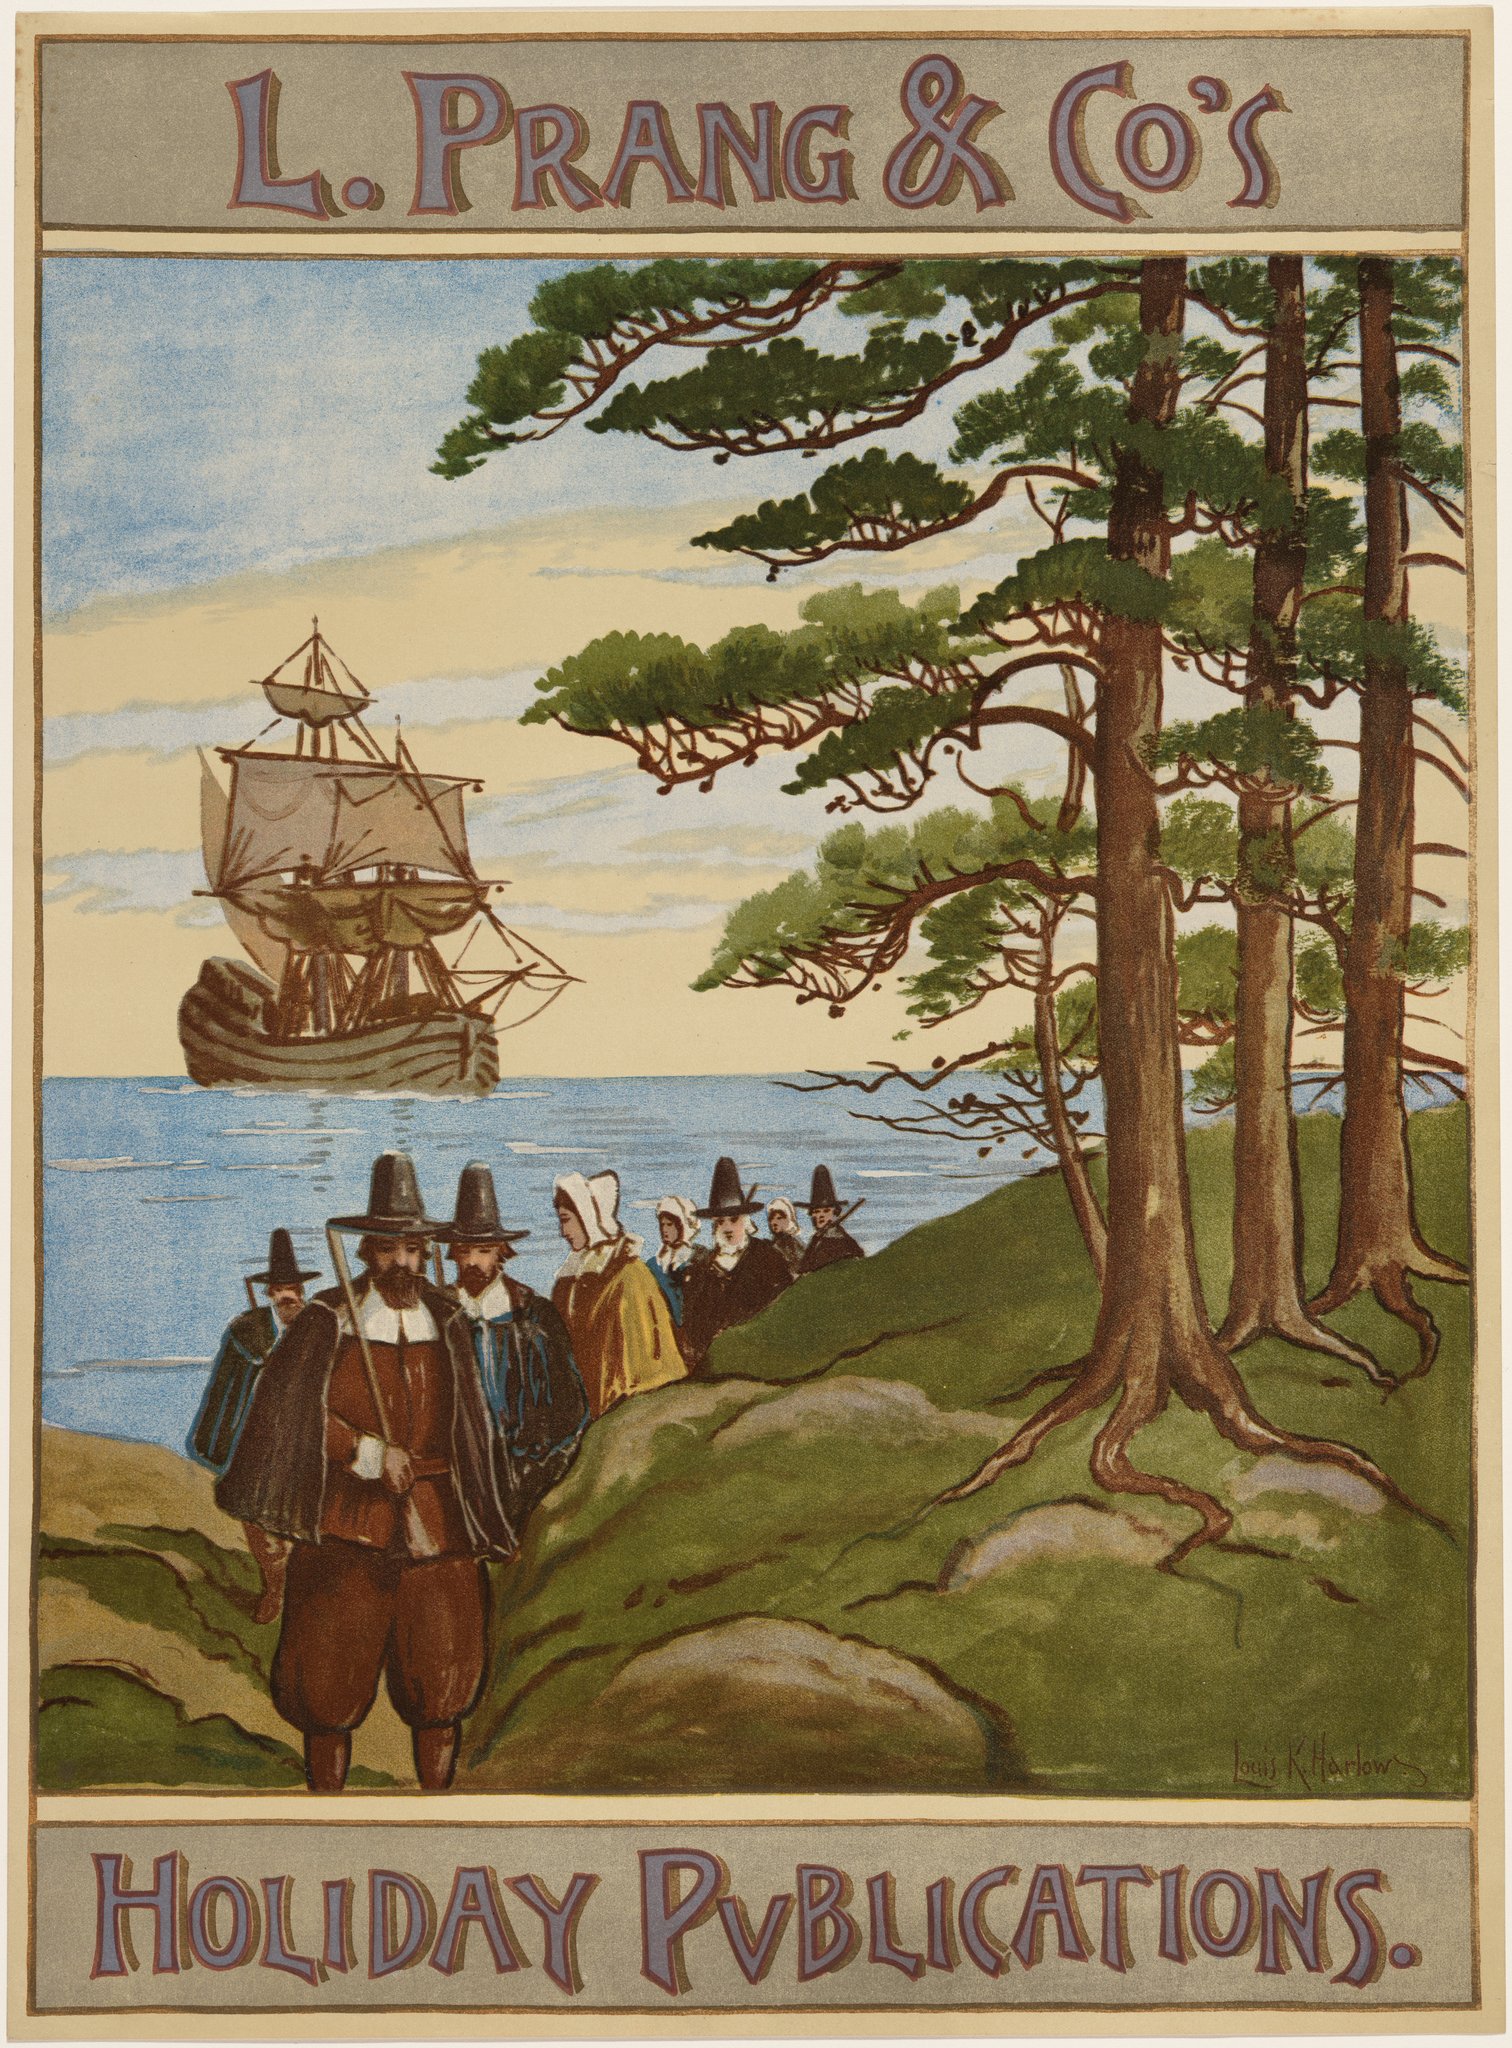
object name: print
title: Prang and Co. Holiday Publications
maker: louis kinney harlow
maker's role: artist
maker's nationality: american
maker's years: 1850-1913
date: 1801-2000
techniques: lithograph